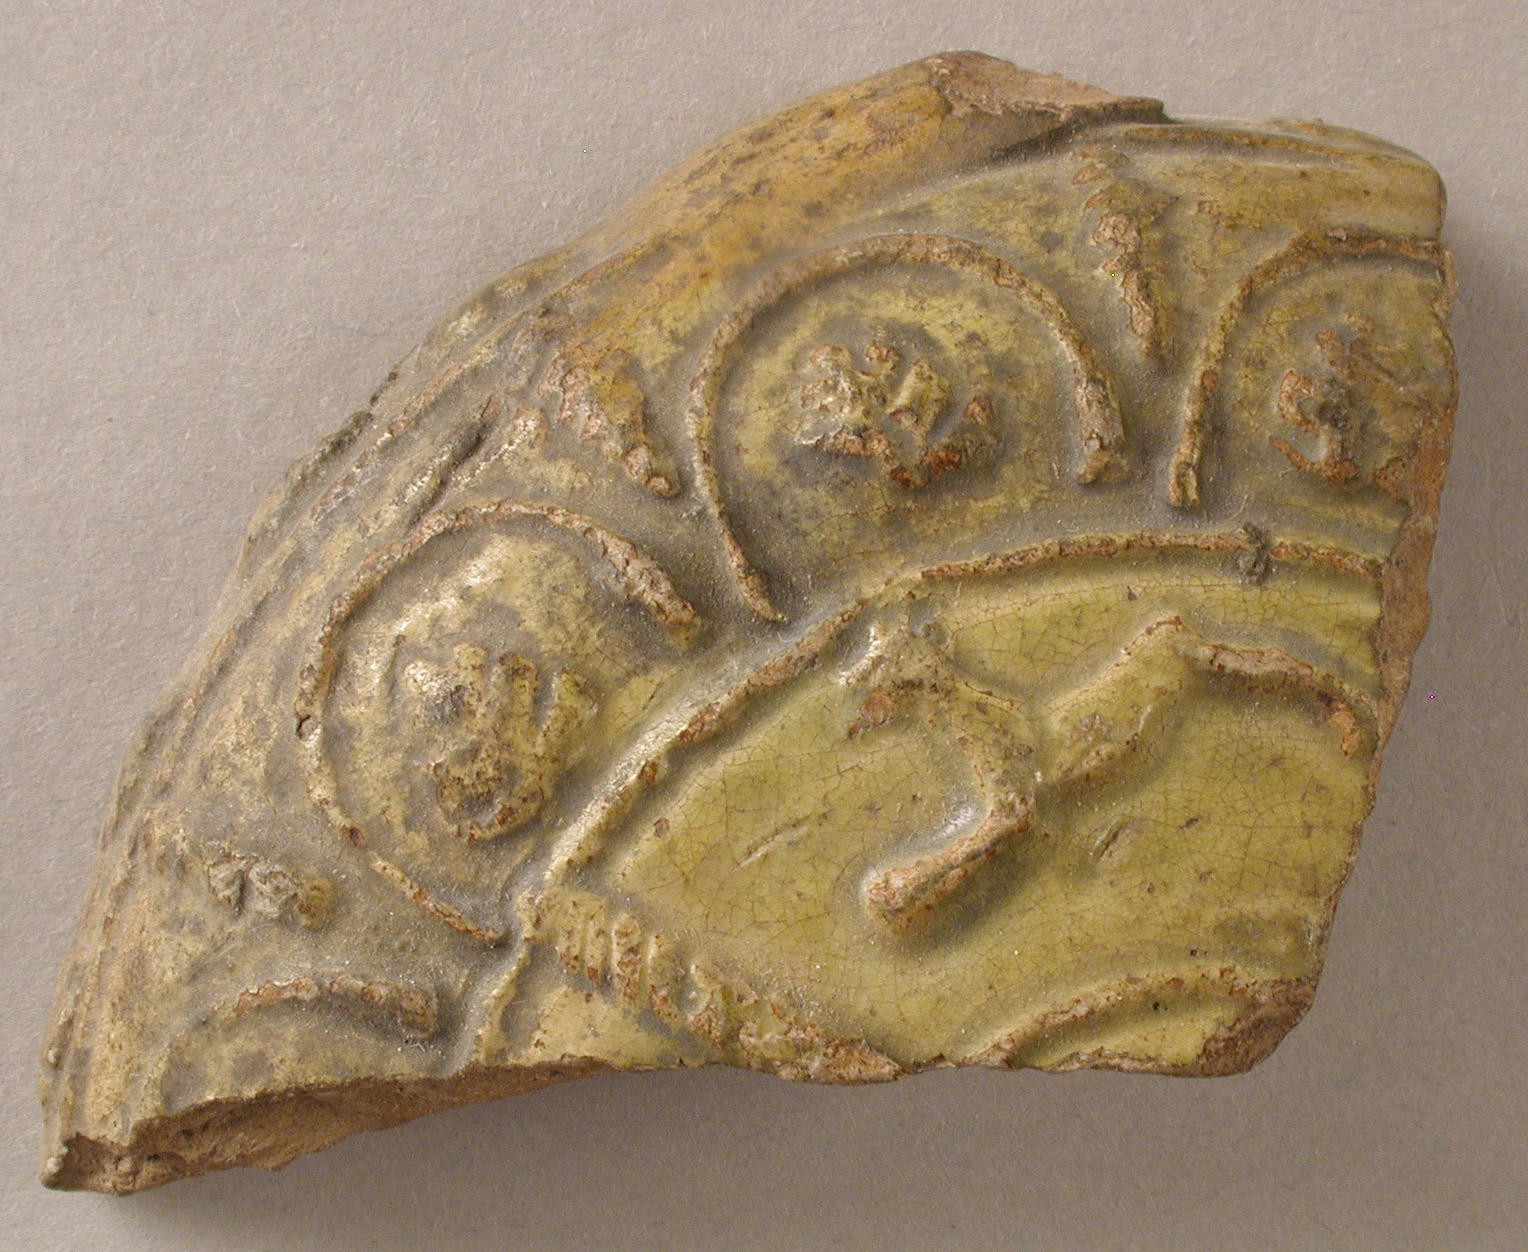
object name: pilgrim bottle fragment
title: Bottle Fragment, Pilgrim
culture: visigothic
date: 801-900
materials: earthenware, glaze